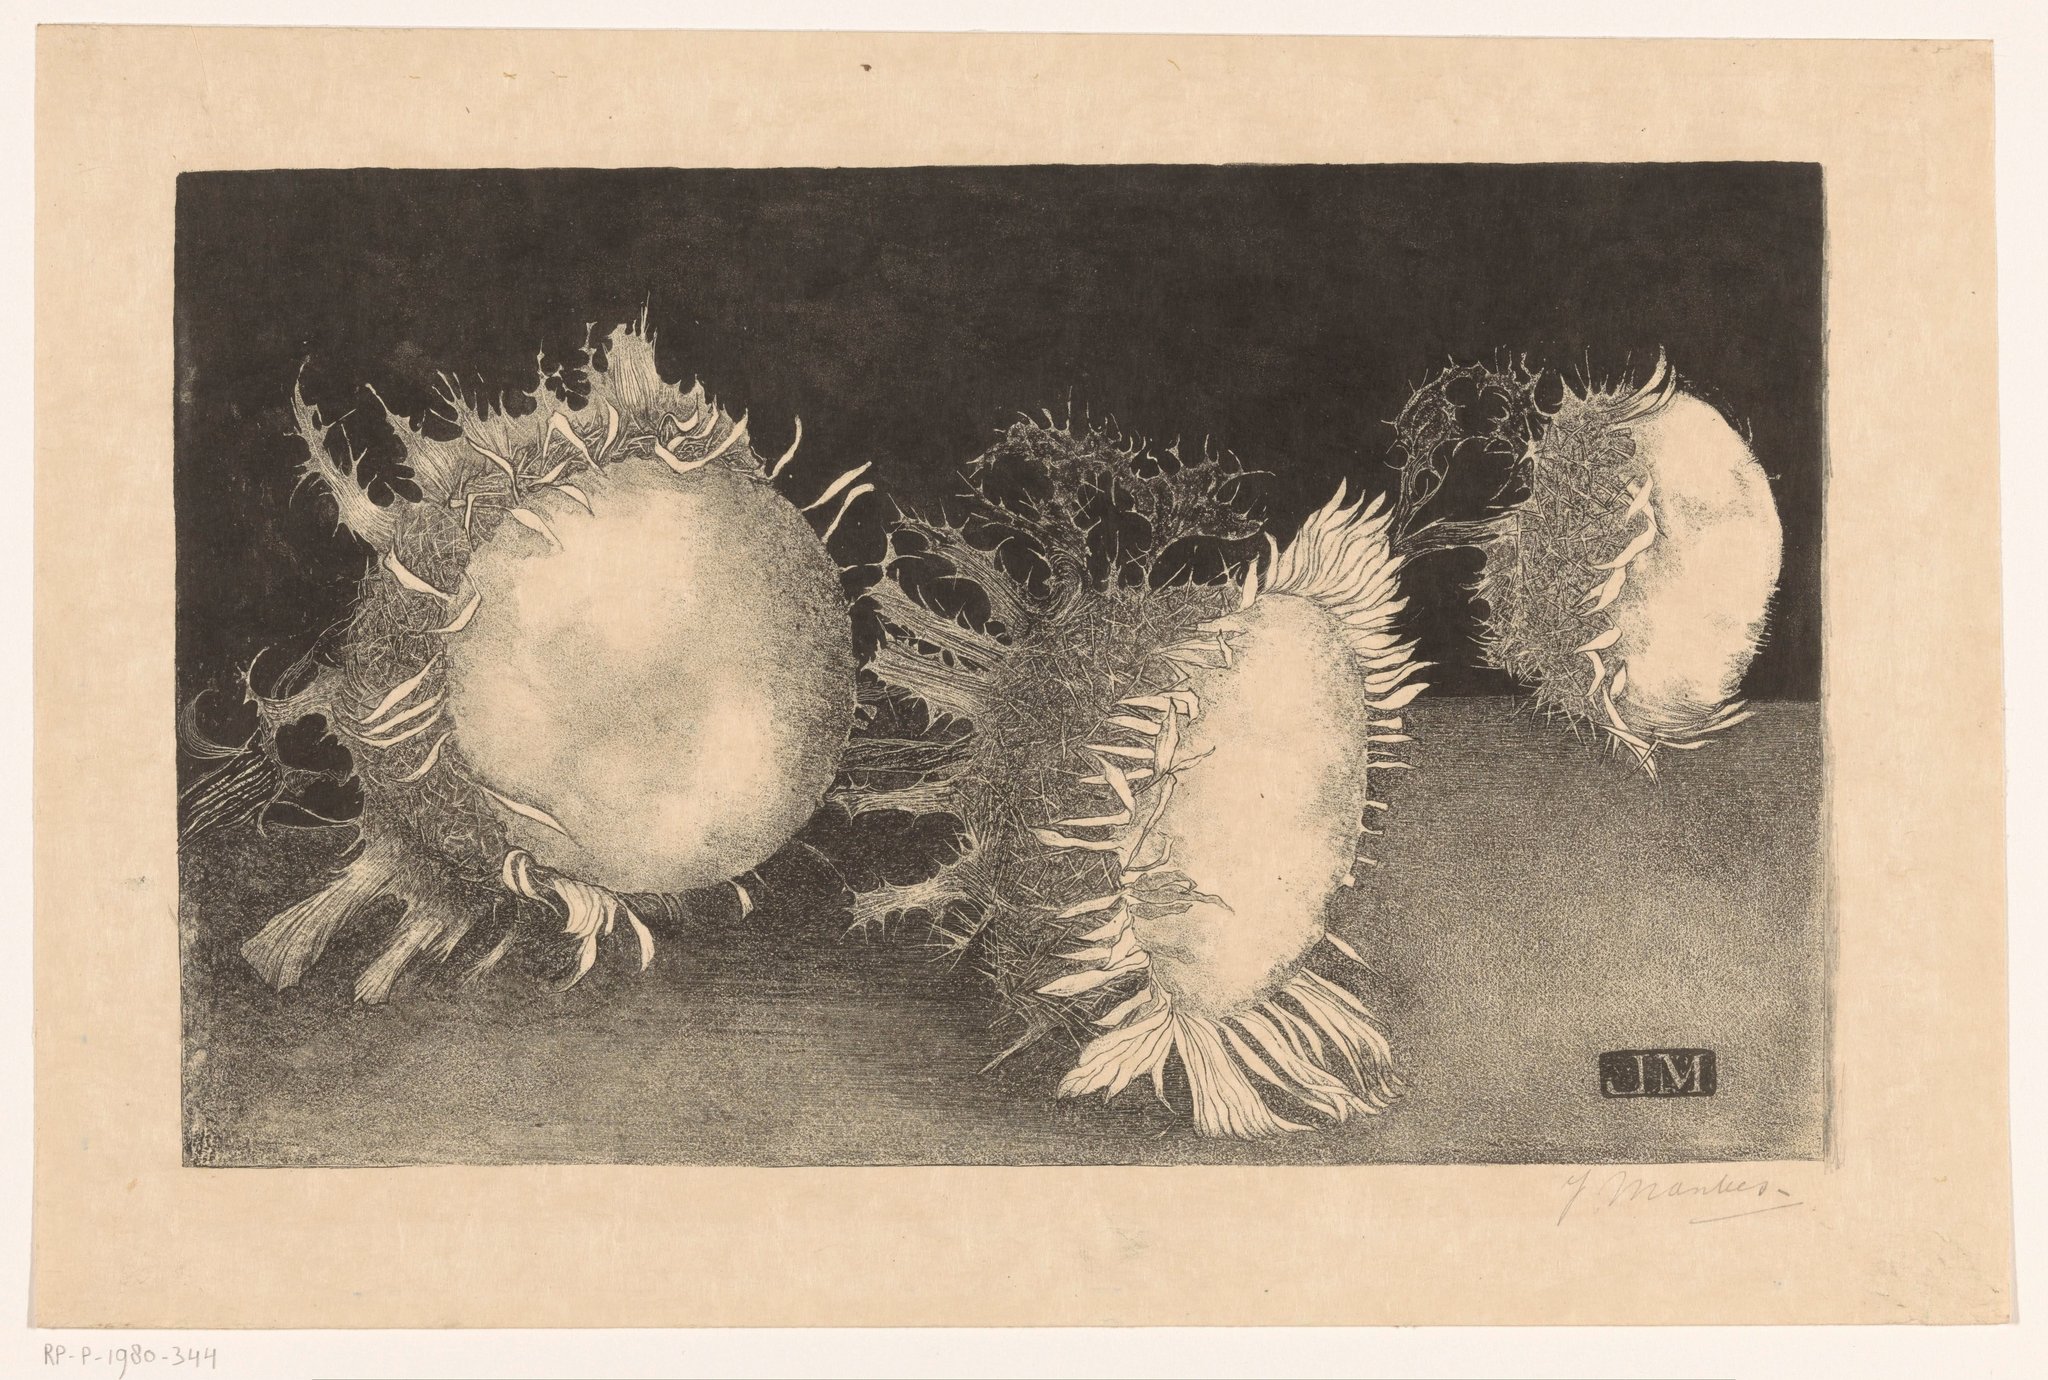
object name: print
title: Drie distelbloemen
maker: jan mankes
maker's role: draughtsman, painter, print maker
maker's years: 1889-1920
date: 1915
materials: paper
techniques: lithograph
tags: plants and herbs: thistle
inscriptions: collector's mark: Lugt 2228